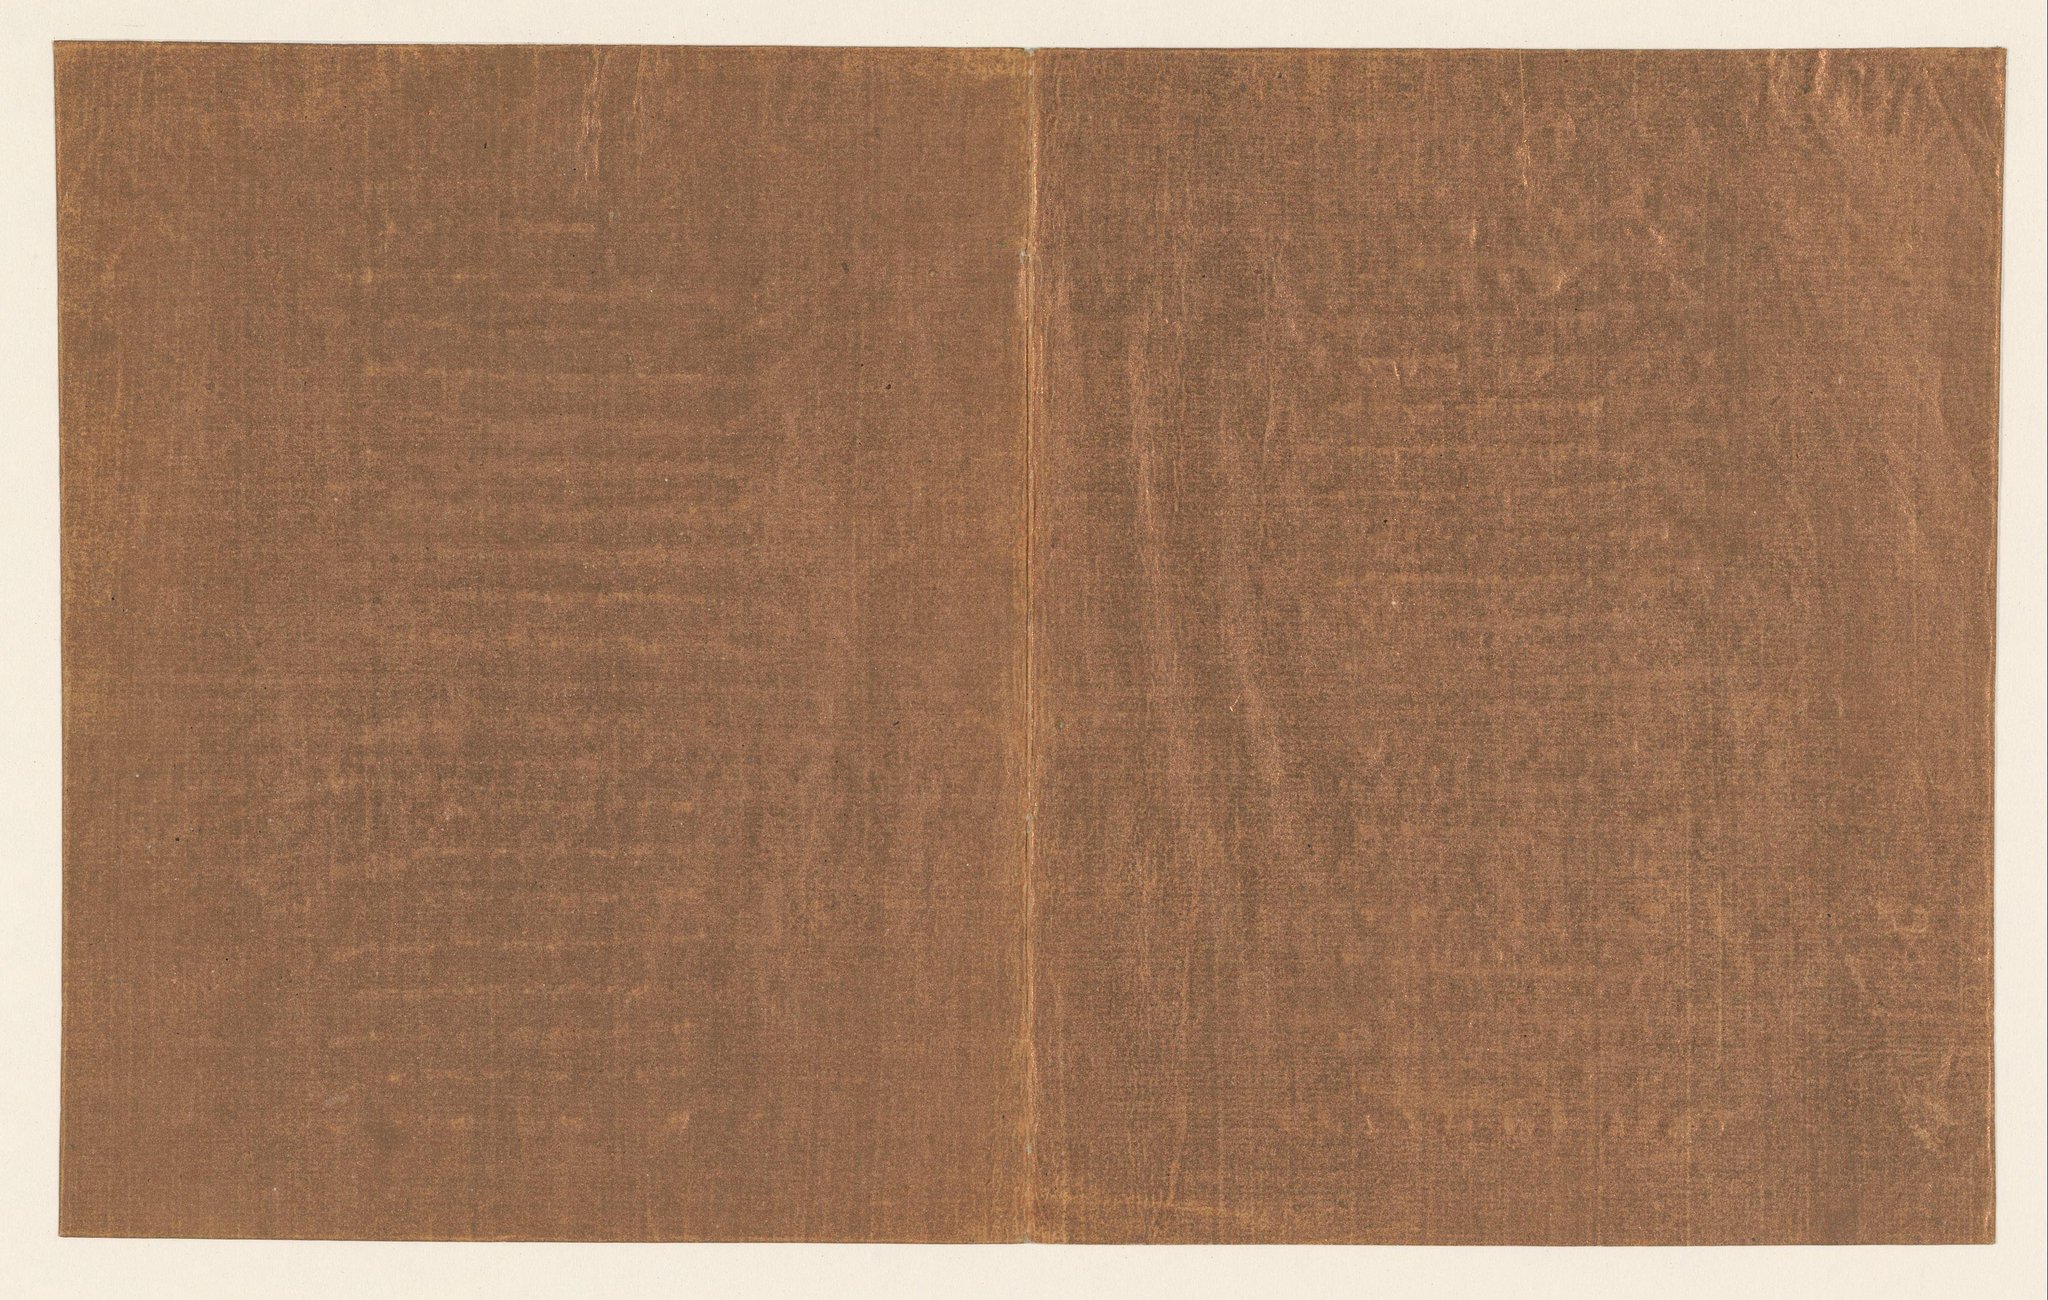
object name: wrapper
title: Blad effen bronskleurig metaalpapier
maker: Anonymous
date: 1700-1850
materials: paper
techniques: printing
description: Blad effen bronskleurig metaalpapier. Gebruikt als omslag.